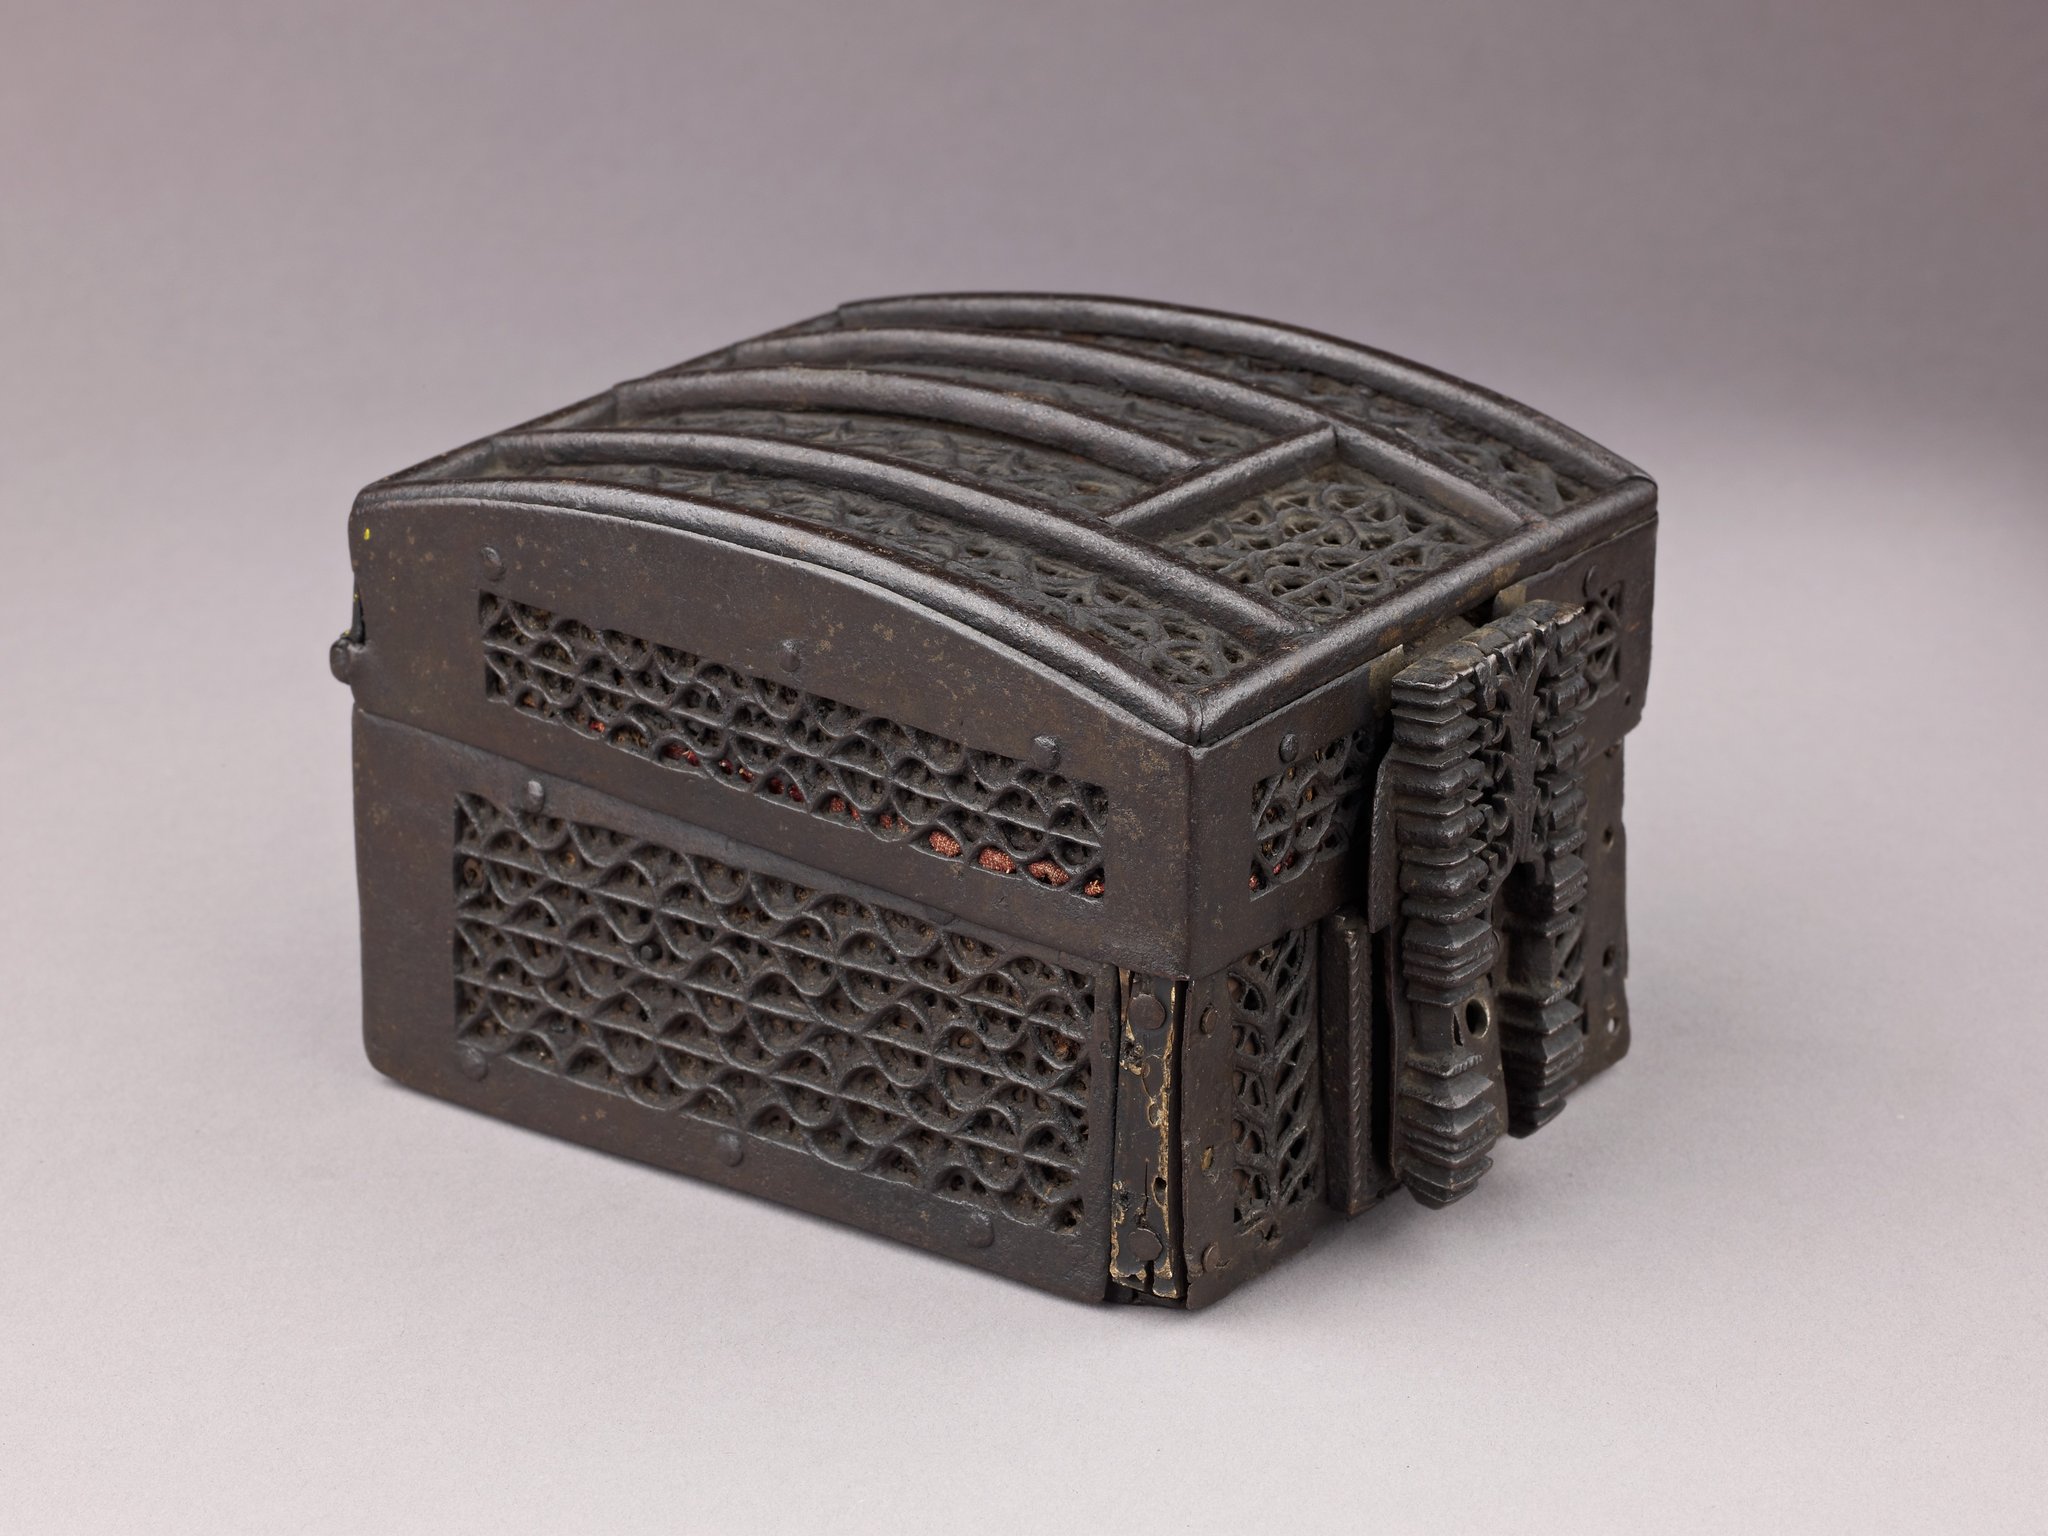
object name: strongbox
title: Coffret à mailles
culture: french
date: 1467-1500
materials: wood, iron